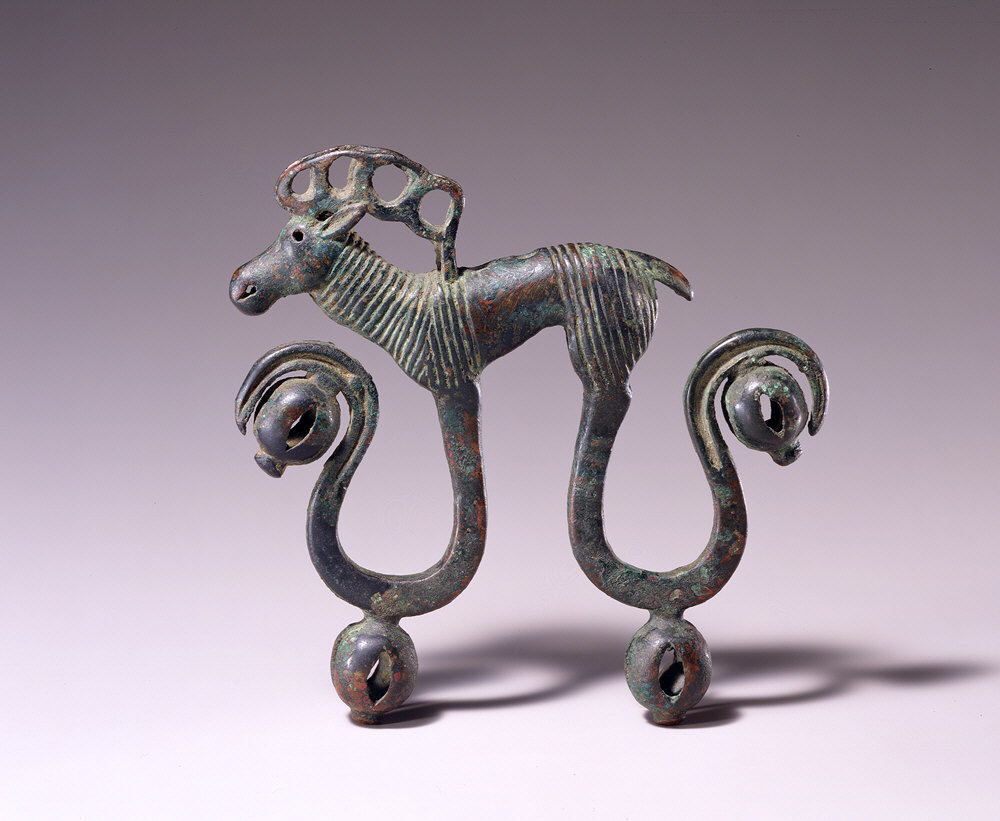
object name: harness jingle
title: Harness Jingle with Stag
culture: chinese, northeast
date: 700-501 BCE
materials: bronze